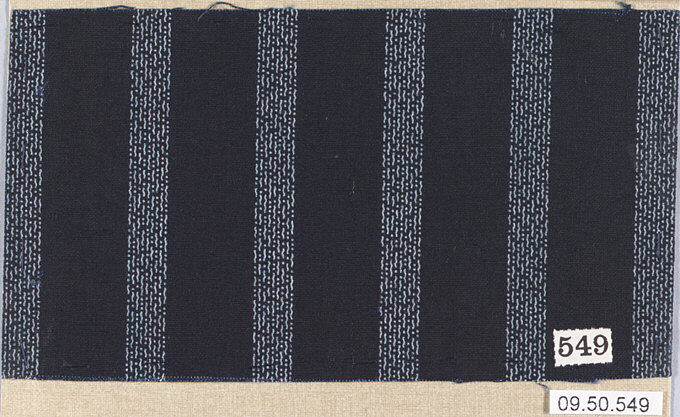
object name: piece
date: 1801-1900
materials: cotton